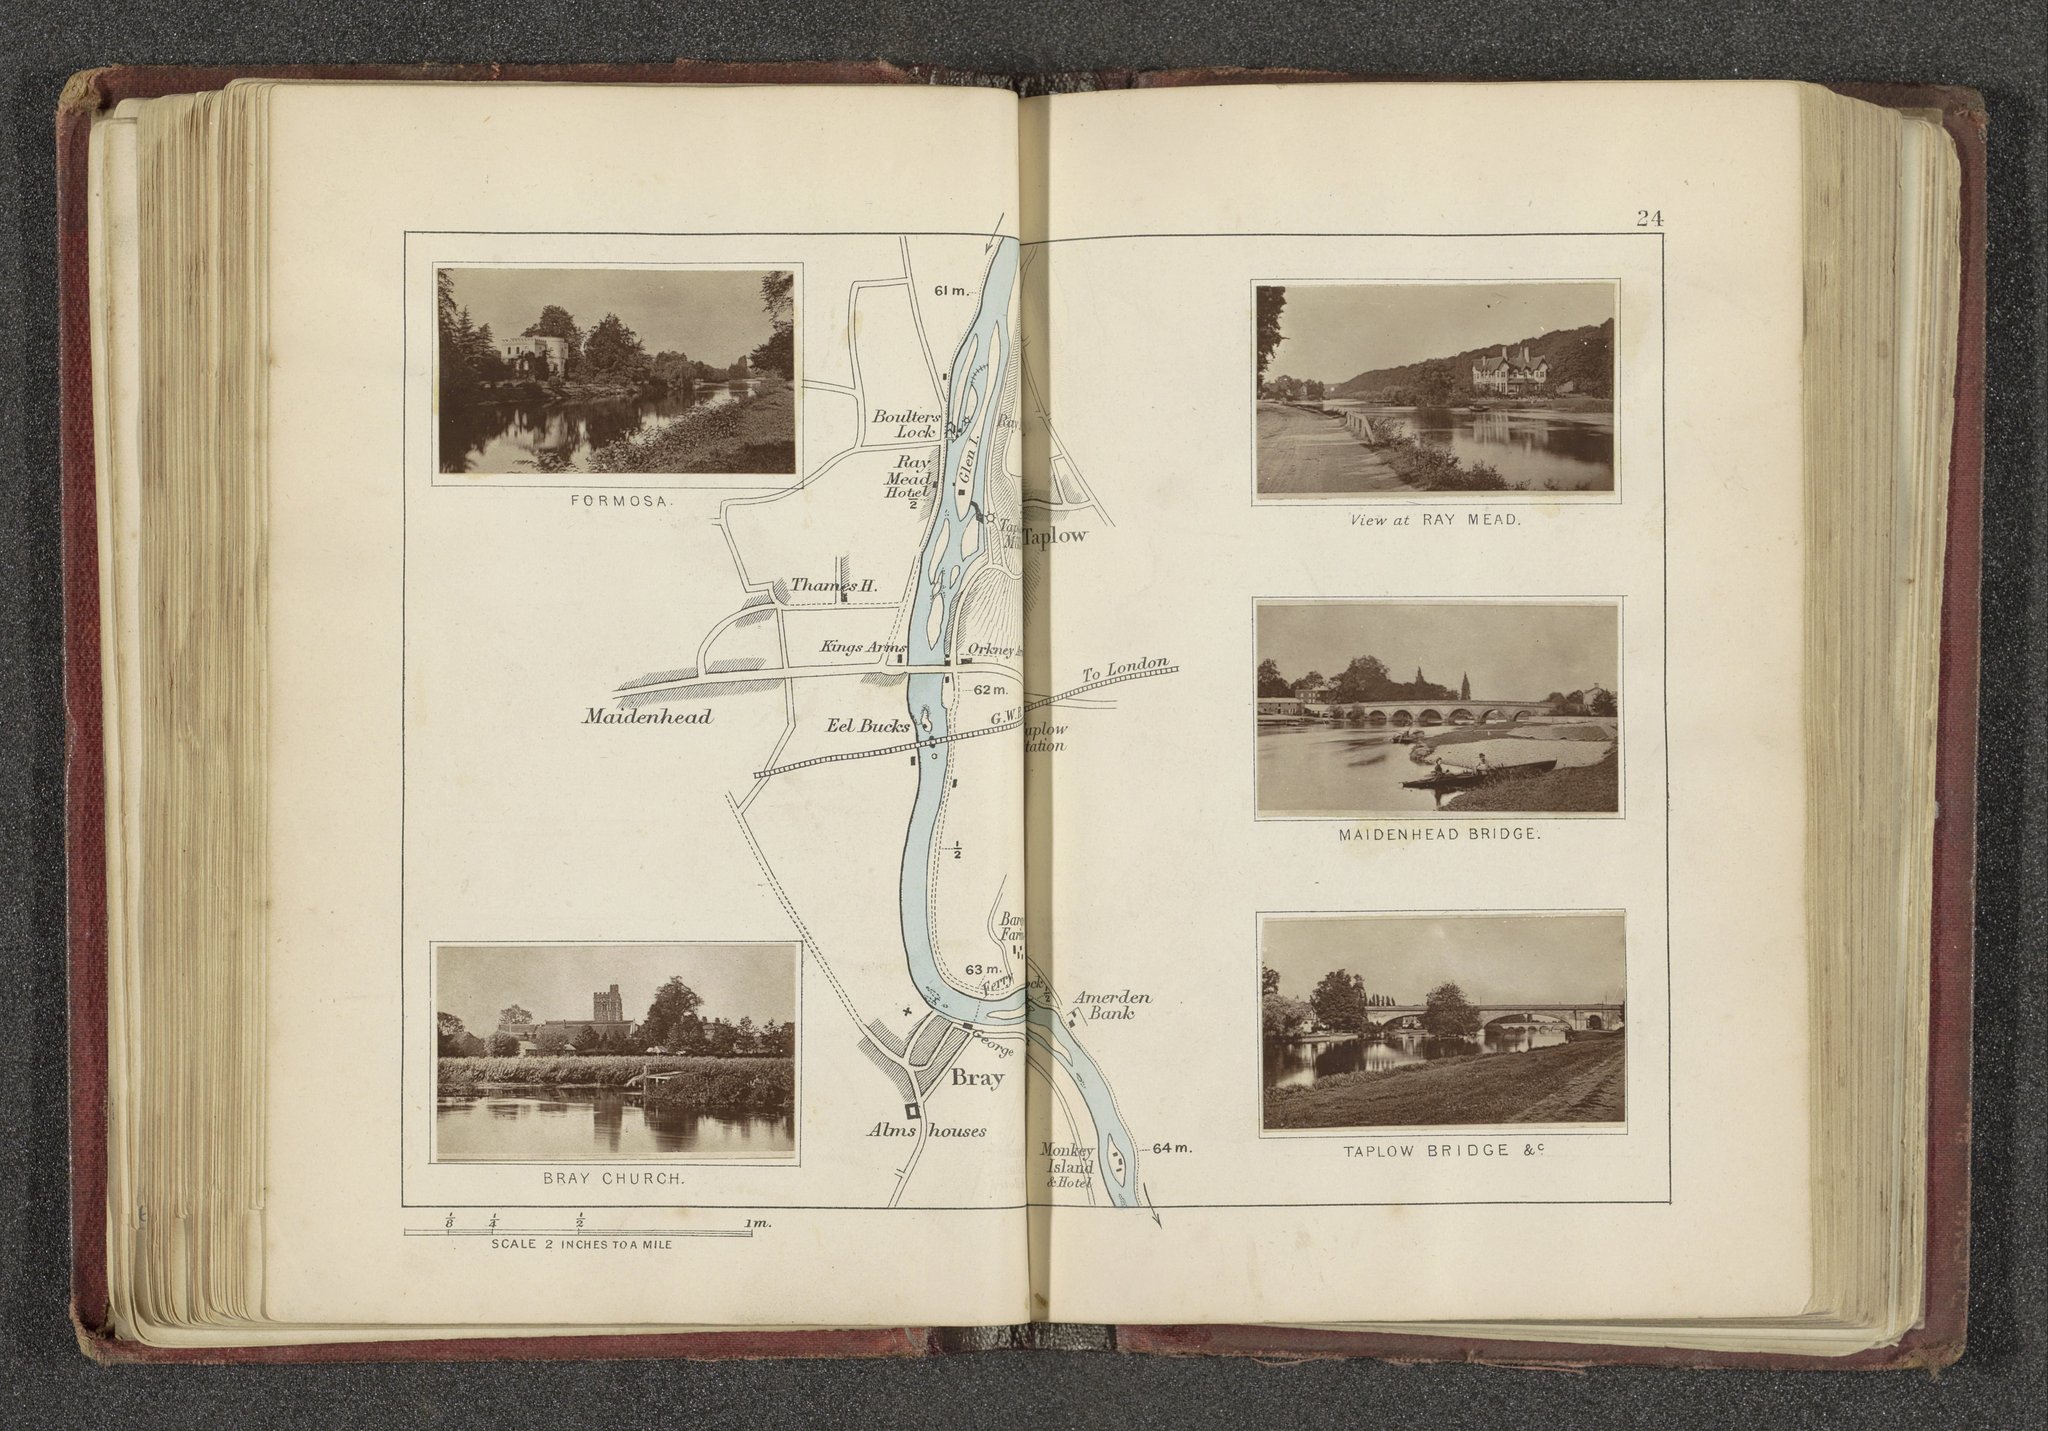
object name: photomechanical print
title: Kaart met vijf afbeeldingen van plaatsen langs de Theems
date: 1878-1879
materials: paper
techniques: engraving, woodburytype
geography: england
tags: island, river, bridge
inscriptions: inscription: ‘Formosa. Bray church. View at Ray Mead. Maidenhead bridge. Taplow bridge &c.’, number: ‘24’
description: Links: gezicht op Formosa Island en een kerk, rechts: gezicht op Ray Mead, een brug bij Maidenhead en een brug bij Taplow.